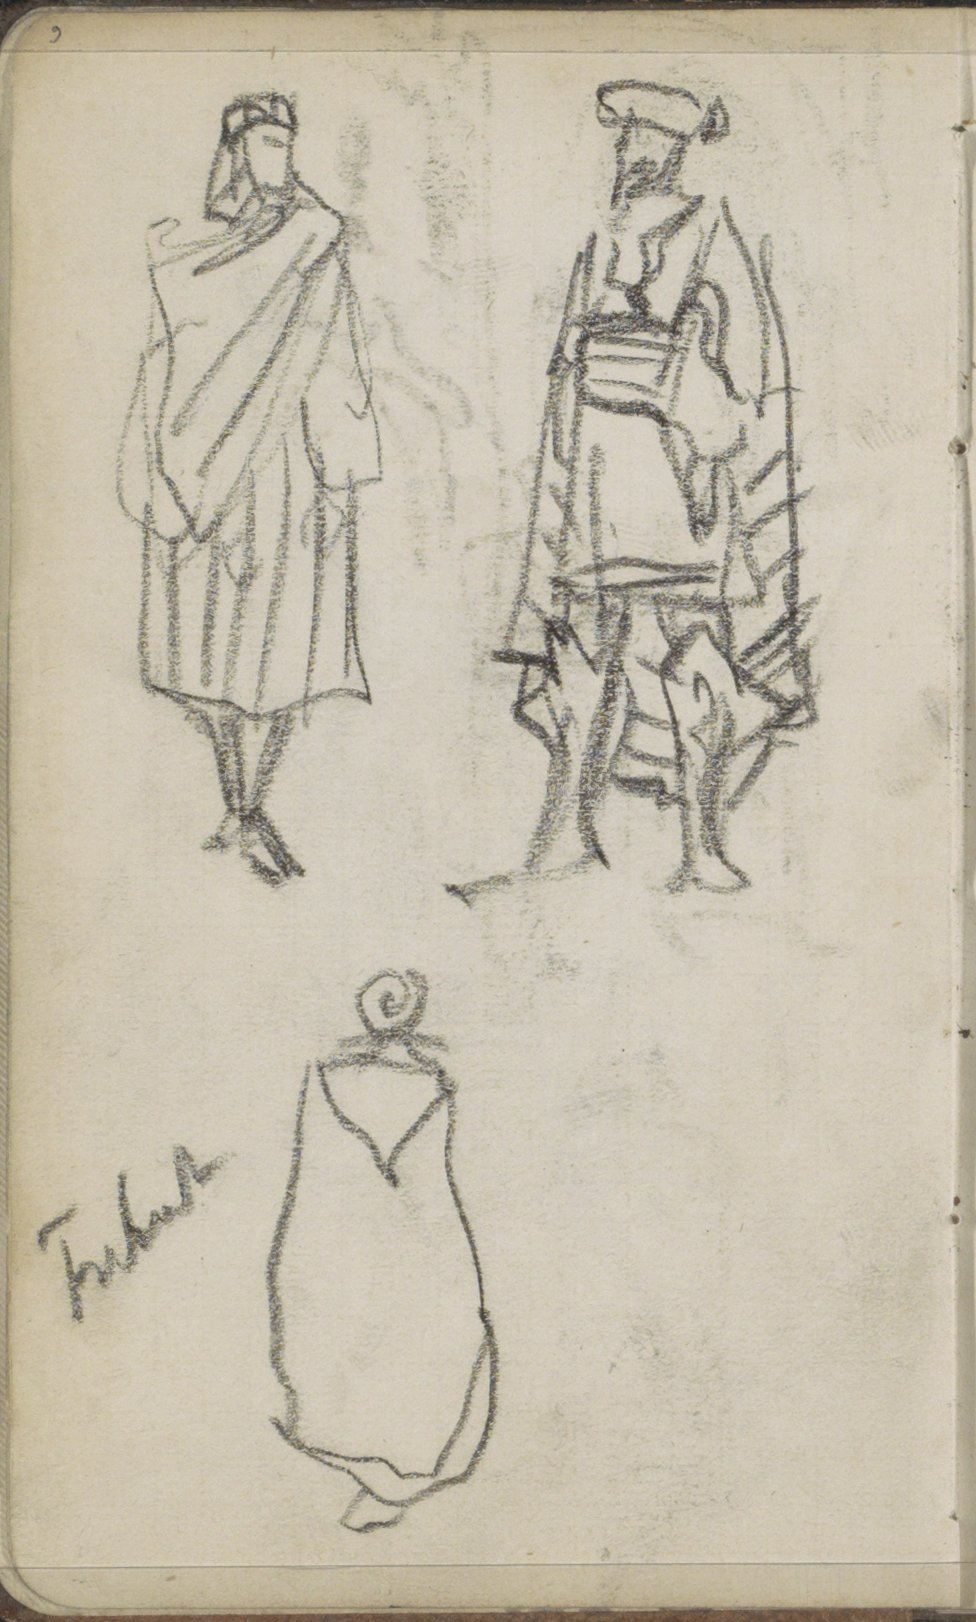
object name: sketchbook leaf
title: Figuren in historisch kostuum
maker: marius bauer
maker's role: draughtsman, print maker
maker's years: 1867-1932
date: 1879-1885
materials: chalk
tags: standing figure, adult man, historical costume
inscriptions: annotation: ‘Tribut’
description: Mogelijk kostuums voor een theaterstuk. Pagina 9 uit een schetsboek met 58 bladen.